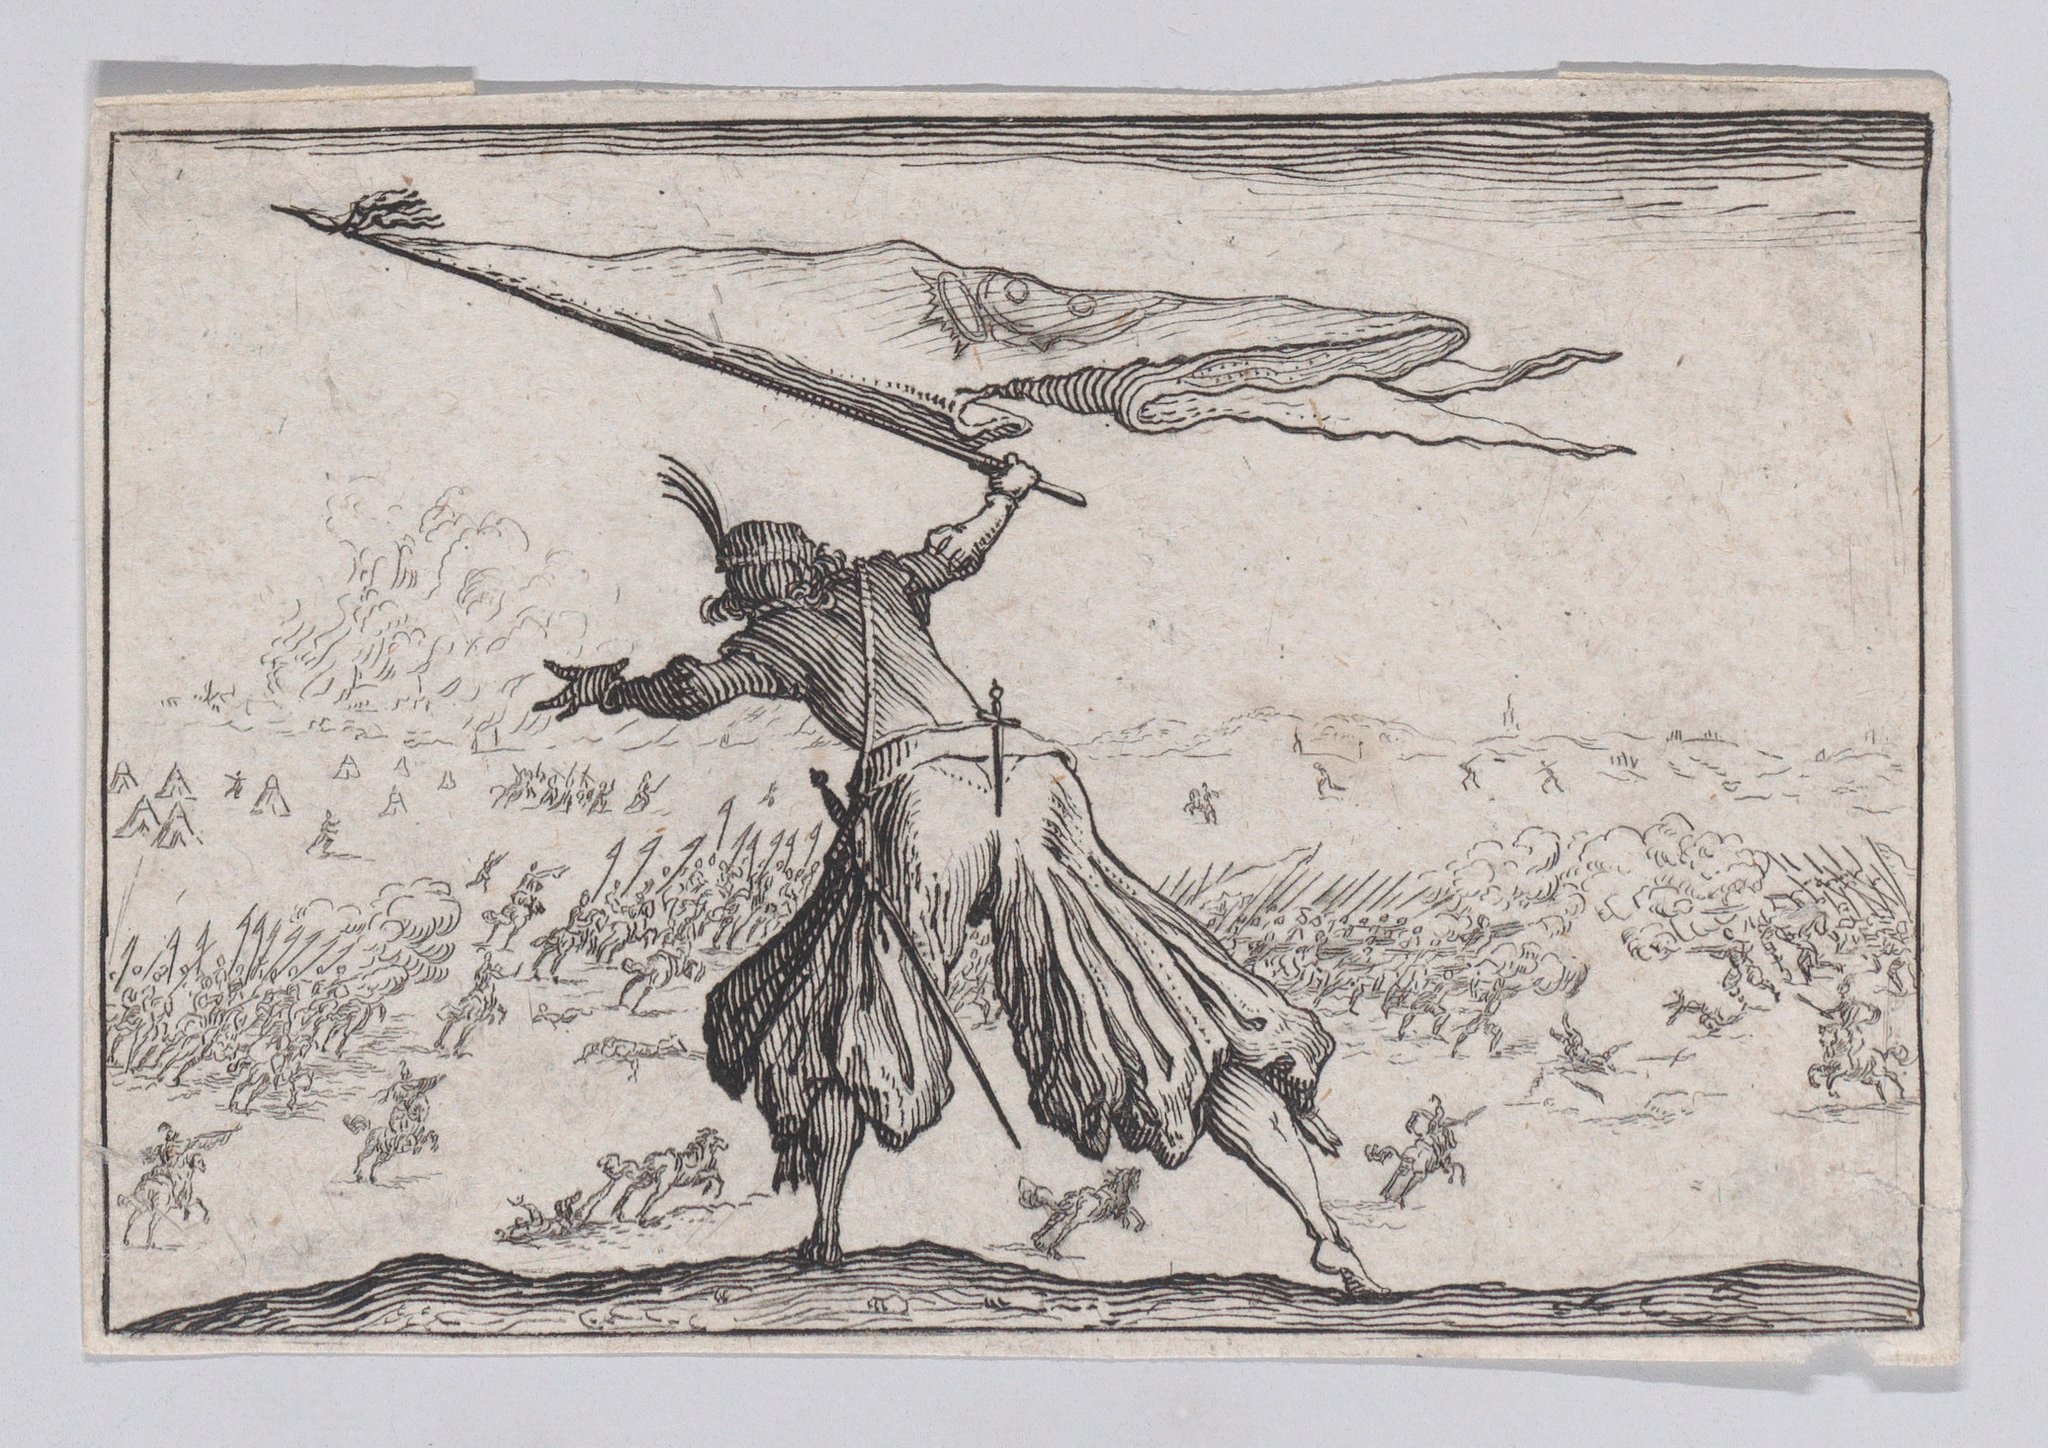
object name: print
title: Copy of Le Porte-Étendard (The Standard Bearer), from "Les Caprices"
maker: Anonymous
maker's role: artist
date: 1601-1700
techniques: etching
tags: men,flags